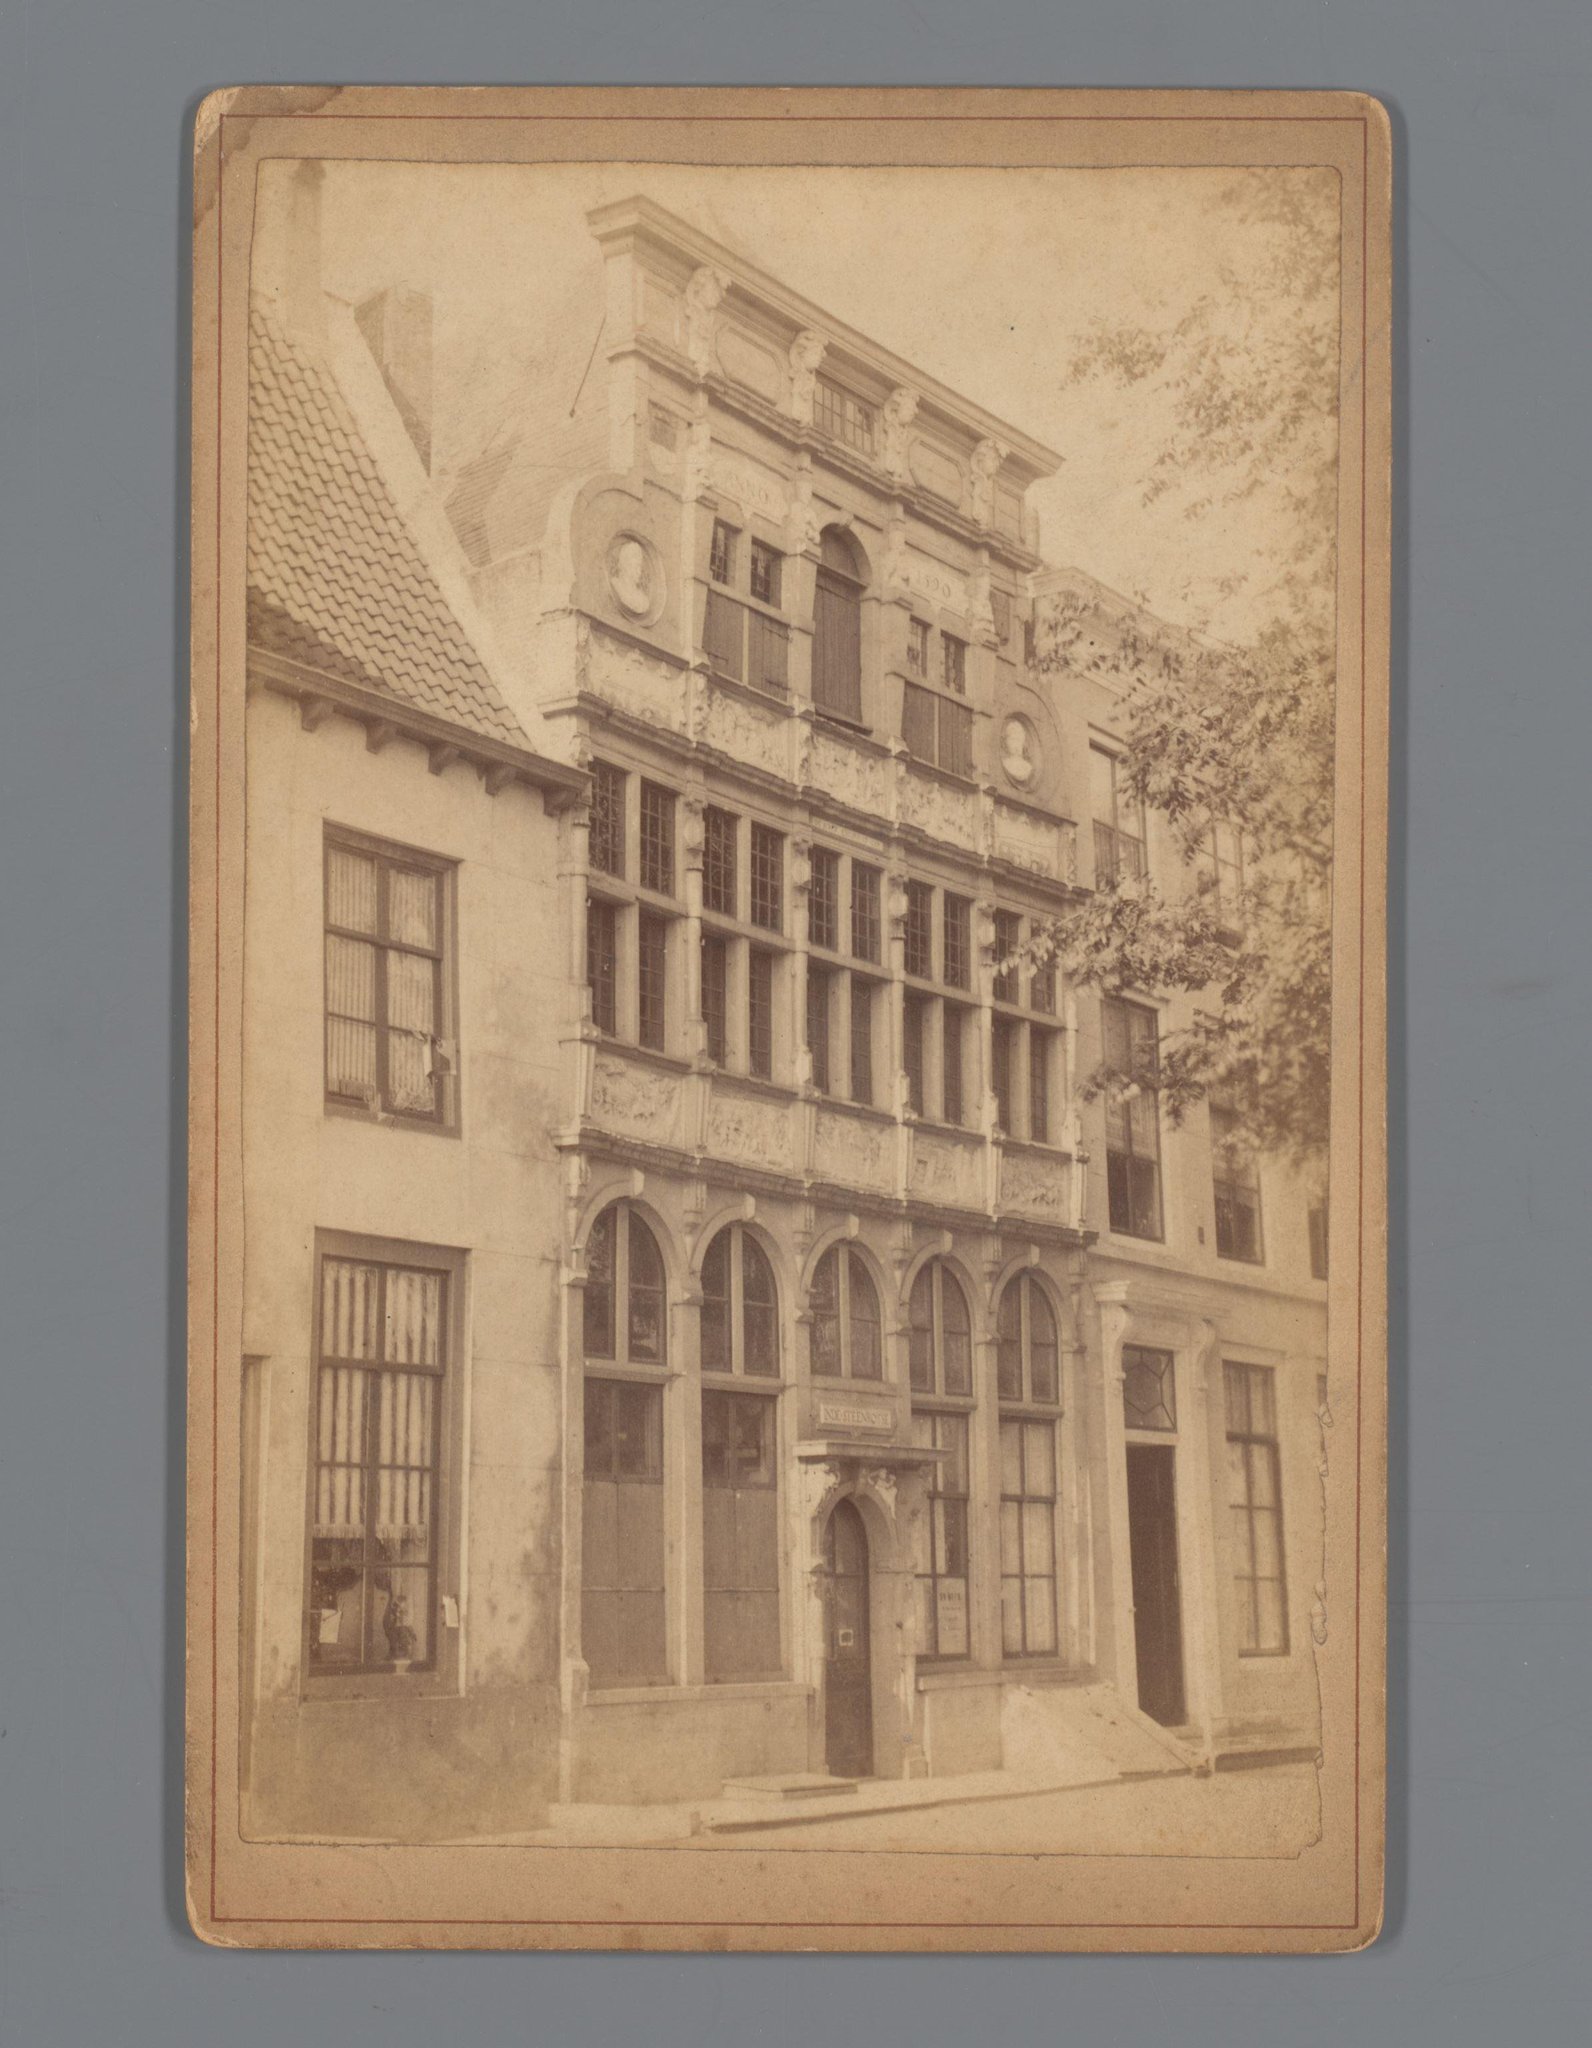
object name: photograph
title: Gevel van De Steenrotse te Middelburg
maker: Anonymous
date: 1870-1900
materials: cardboard, photographic support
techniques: albumen print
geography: middelburg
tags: façade (of house or building), middelburg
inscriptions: annotation: ‘Middelburg’